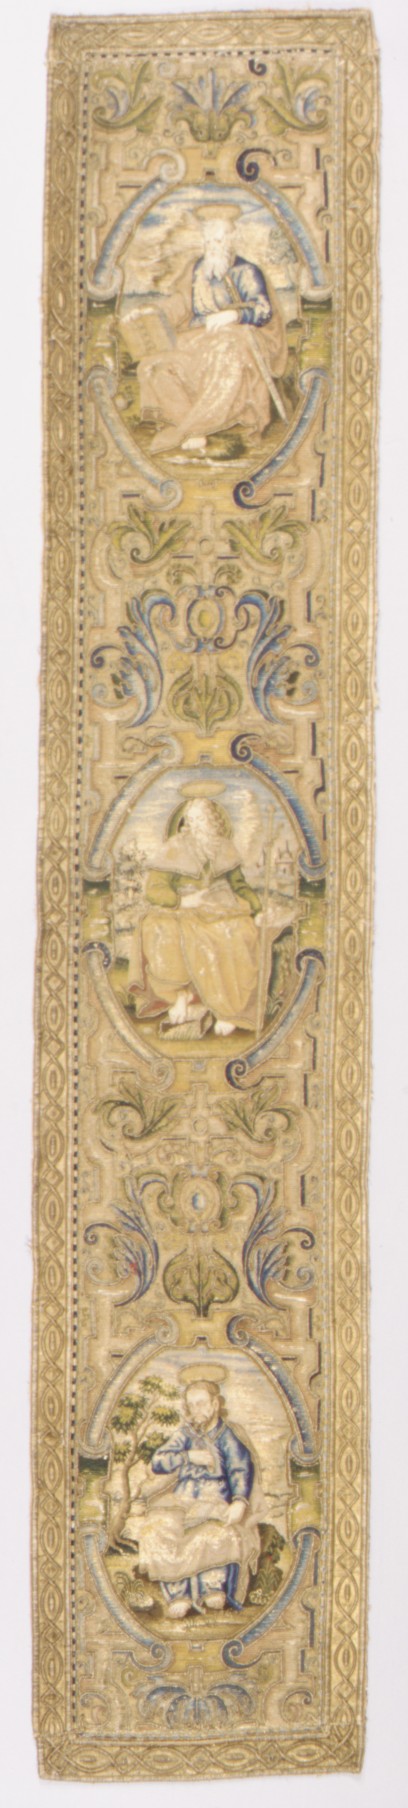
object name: orphrey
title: Saints Paul, James the Greater, and Bartholomew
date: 1501-1600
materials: canvas, metal thread, silk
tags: apostles,saints